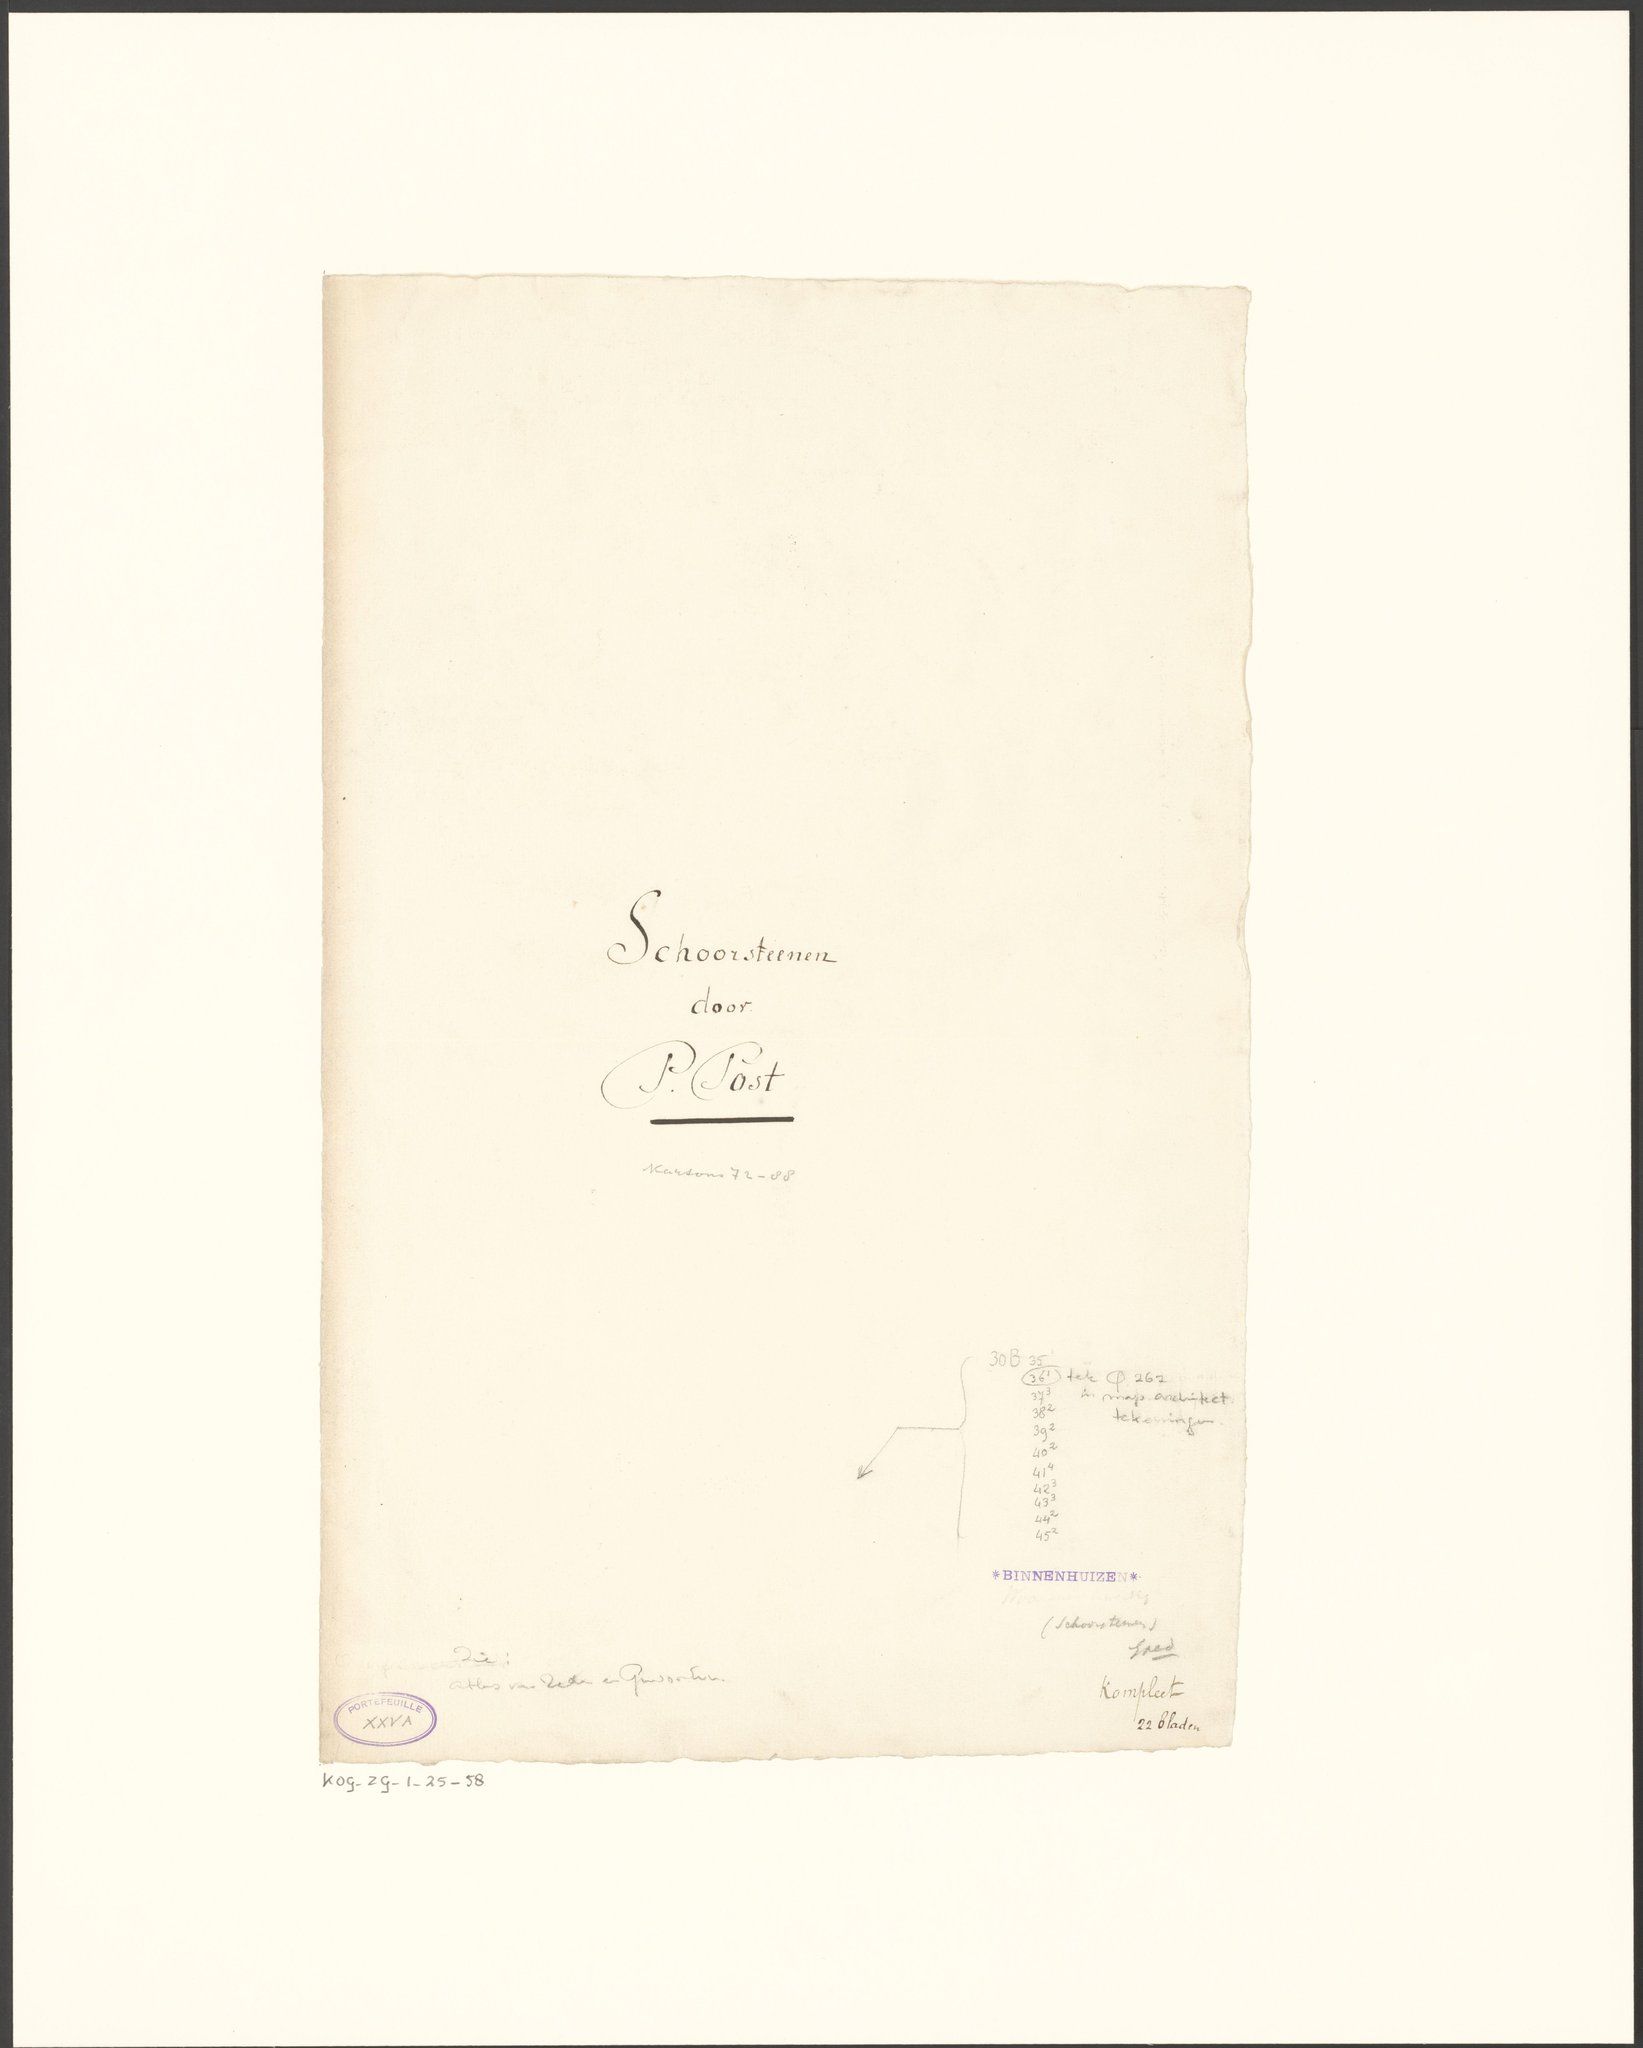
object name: text sheet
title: Schoorsteenen door P. Post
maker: Anonymous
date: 1669-1900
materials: ink, paper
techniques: pen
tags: chimney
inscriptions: stamp, stamp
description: Rechtsonder: Kompleet 22 bladen. Onderwerpsrubrieken binnen de Atlas Zeden en Gewoonten: Zeden en Gewoonten in Engeren Zin, De Woning, Binnenhuizen, Schoorsteenen.